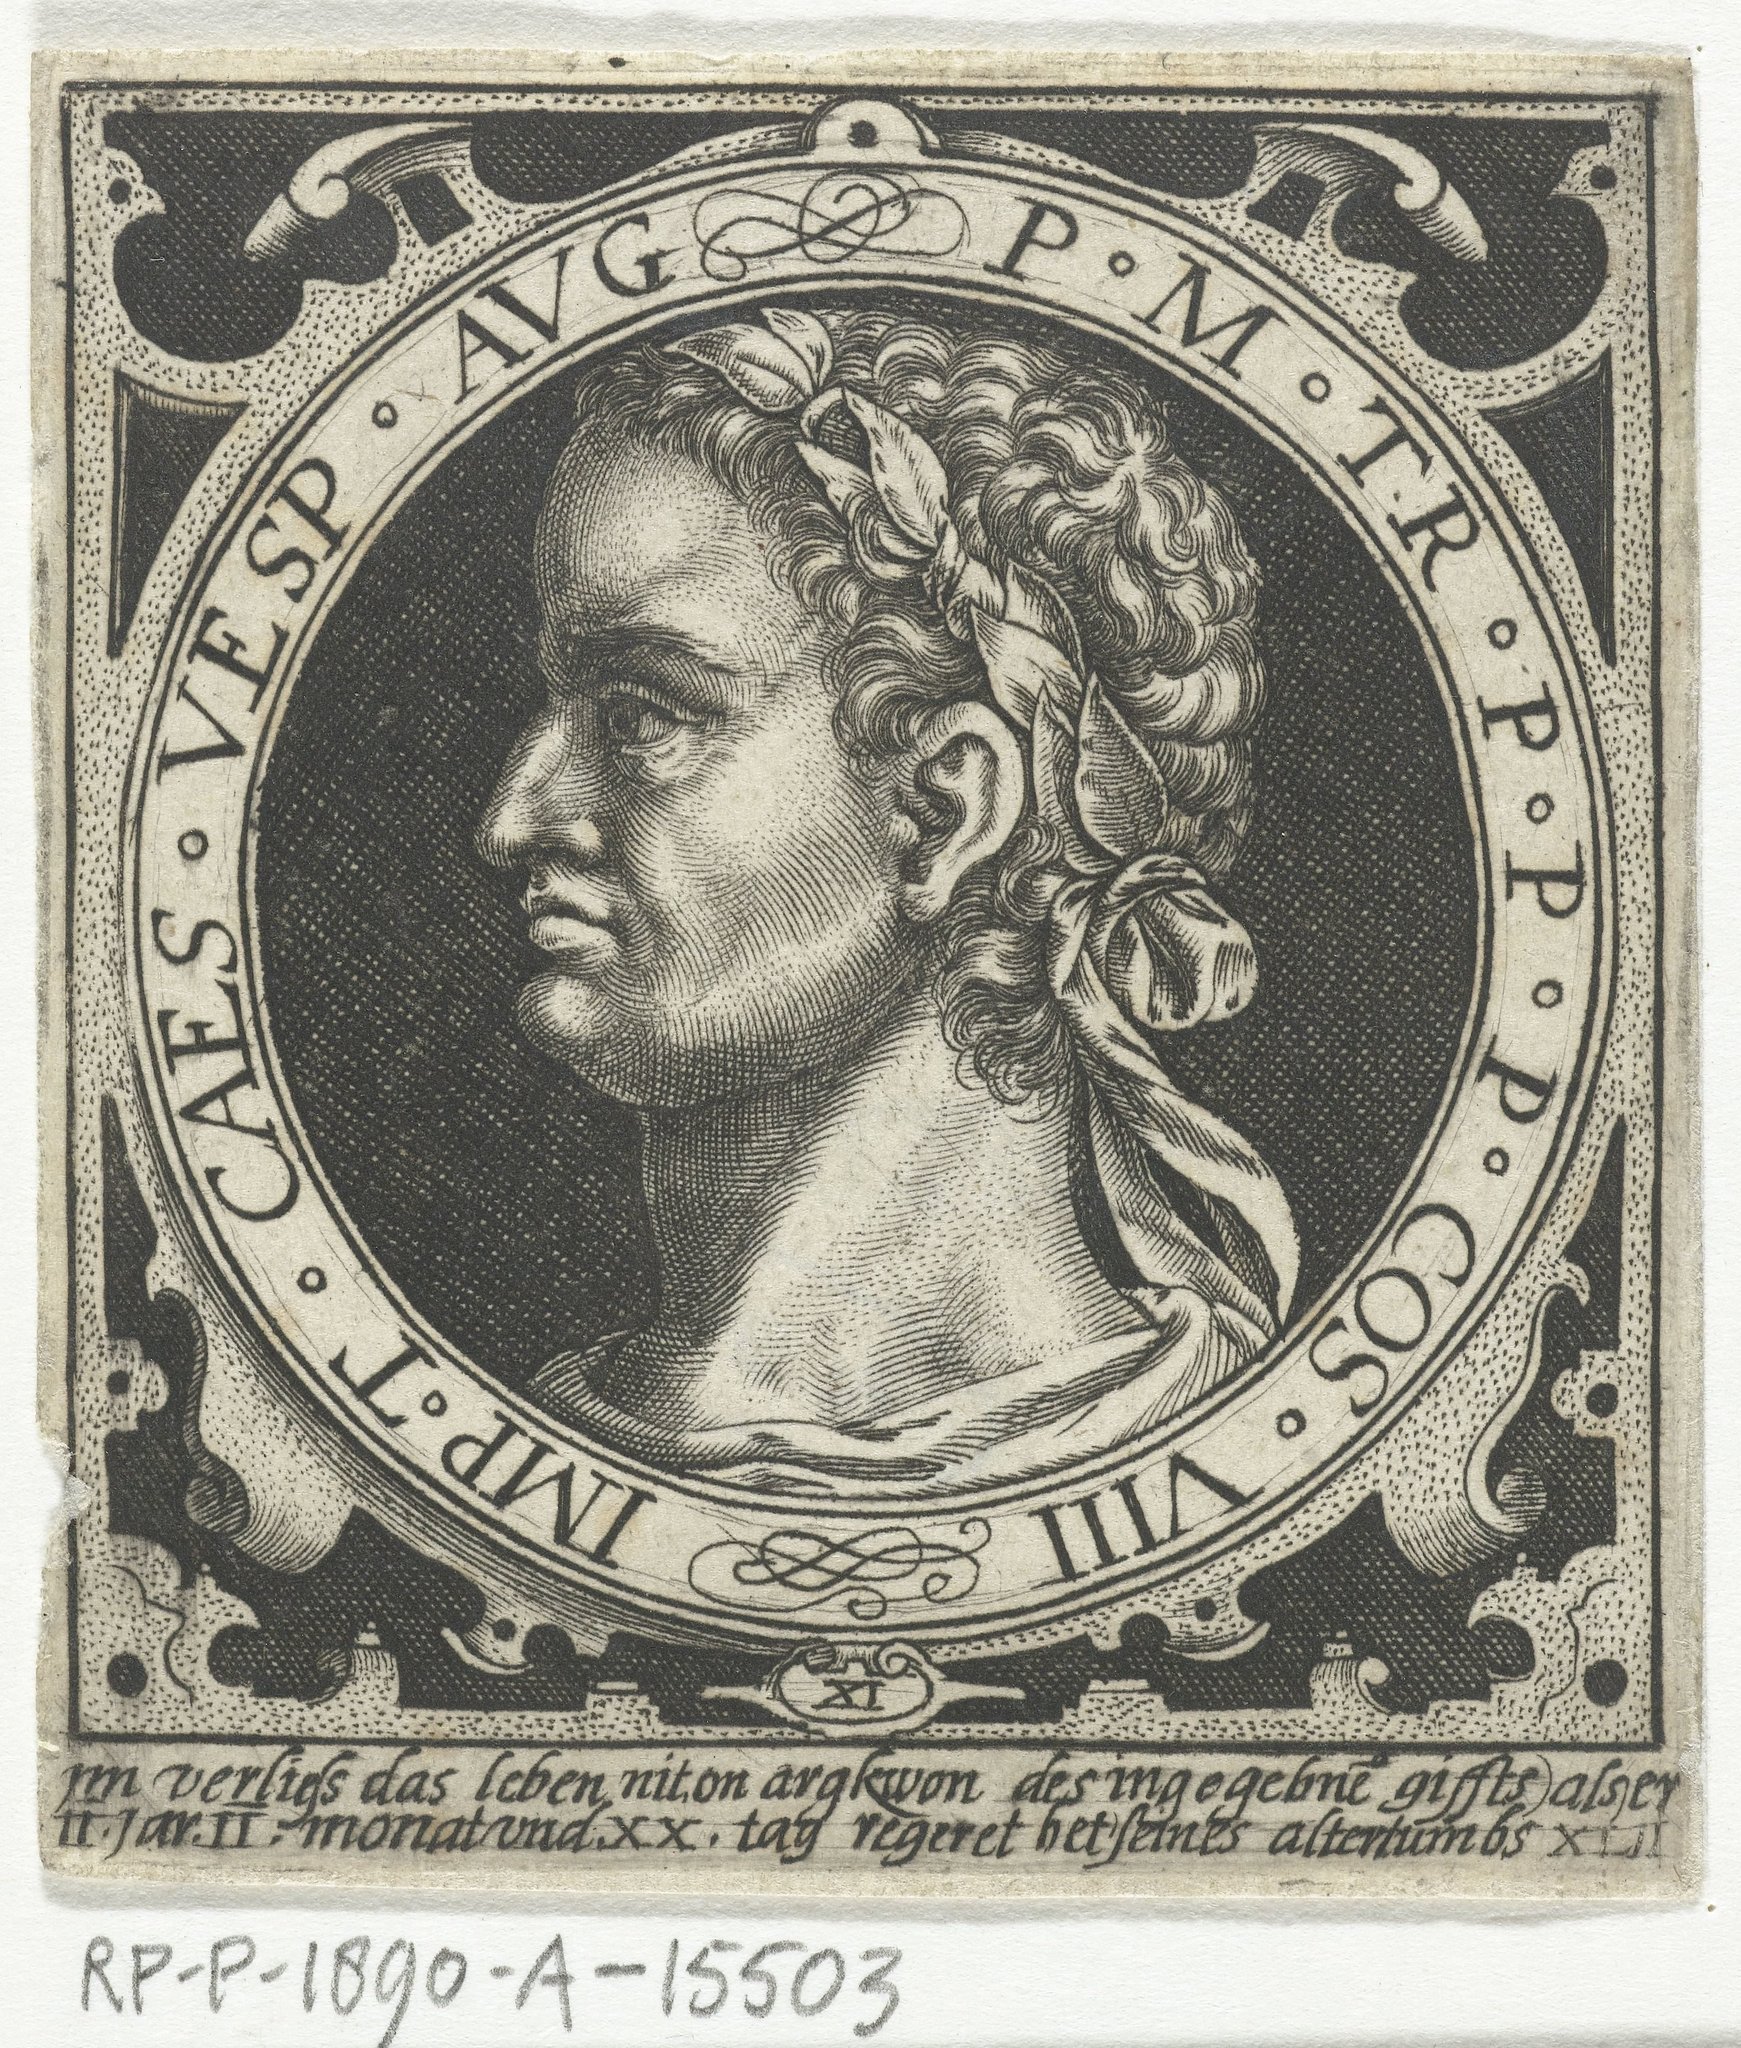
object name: print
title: Portret van Vespasianus op medaillon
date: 1594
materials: paper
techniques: engraving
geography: netherlands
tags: (story of) the emperor vespasian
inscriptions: collector's mark: Lugt 2228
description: Portret met buste van keizer Vespasianus op medaillon in rechthoekige omlijsting met ornamenten. Op rand van medaillon titel en naam van keizer. In de marge onder twee regels in Duits over de wijze waarop de keizer om het leven kwam.